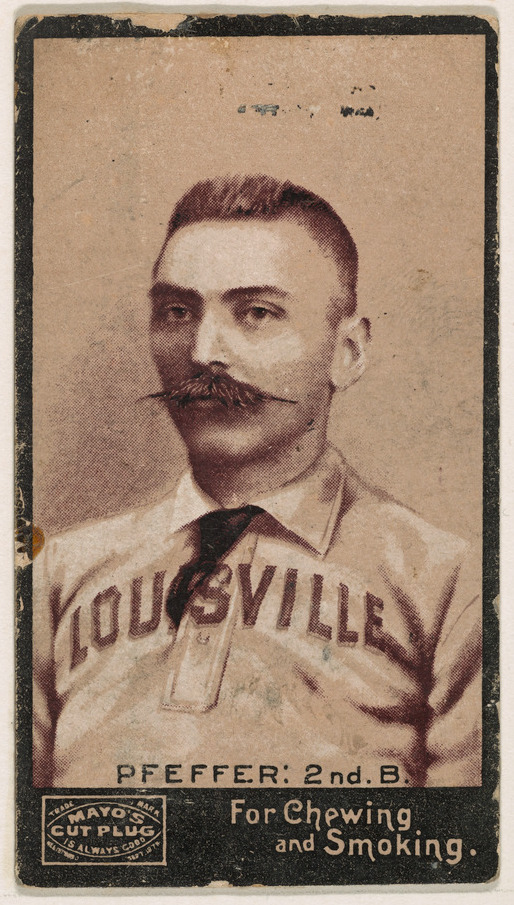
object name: print, baseball card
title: Pfeffer, 2nd Base, Louisville, from Mayo's Cut Plug Baseball series (N300)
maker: p.h. mayo & brother, richmond, virginia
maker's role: publisher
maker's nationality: american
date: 1895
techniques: lithography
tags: men,portraits,baseball,athletes